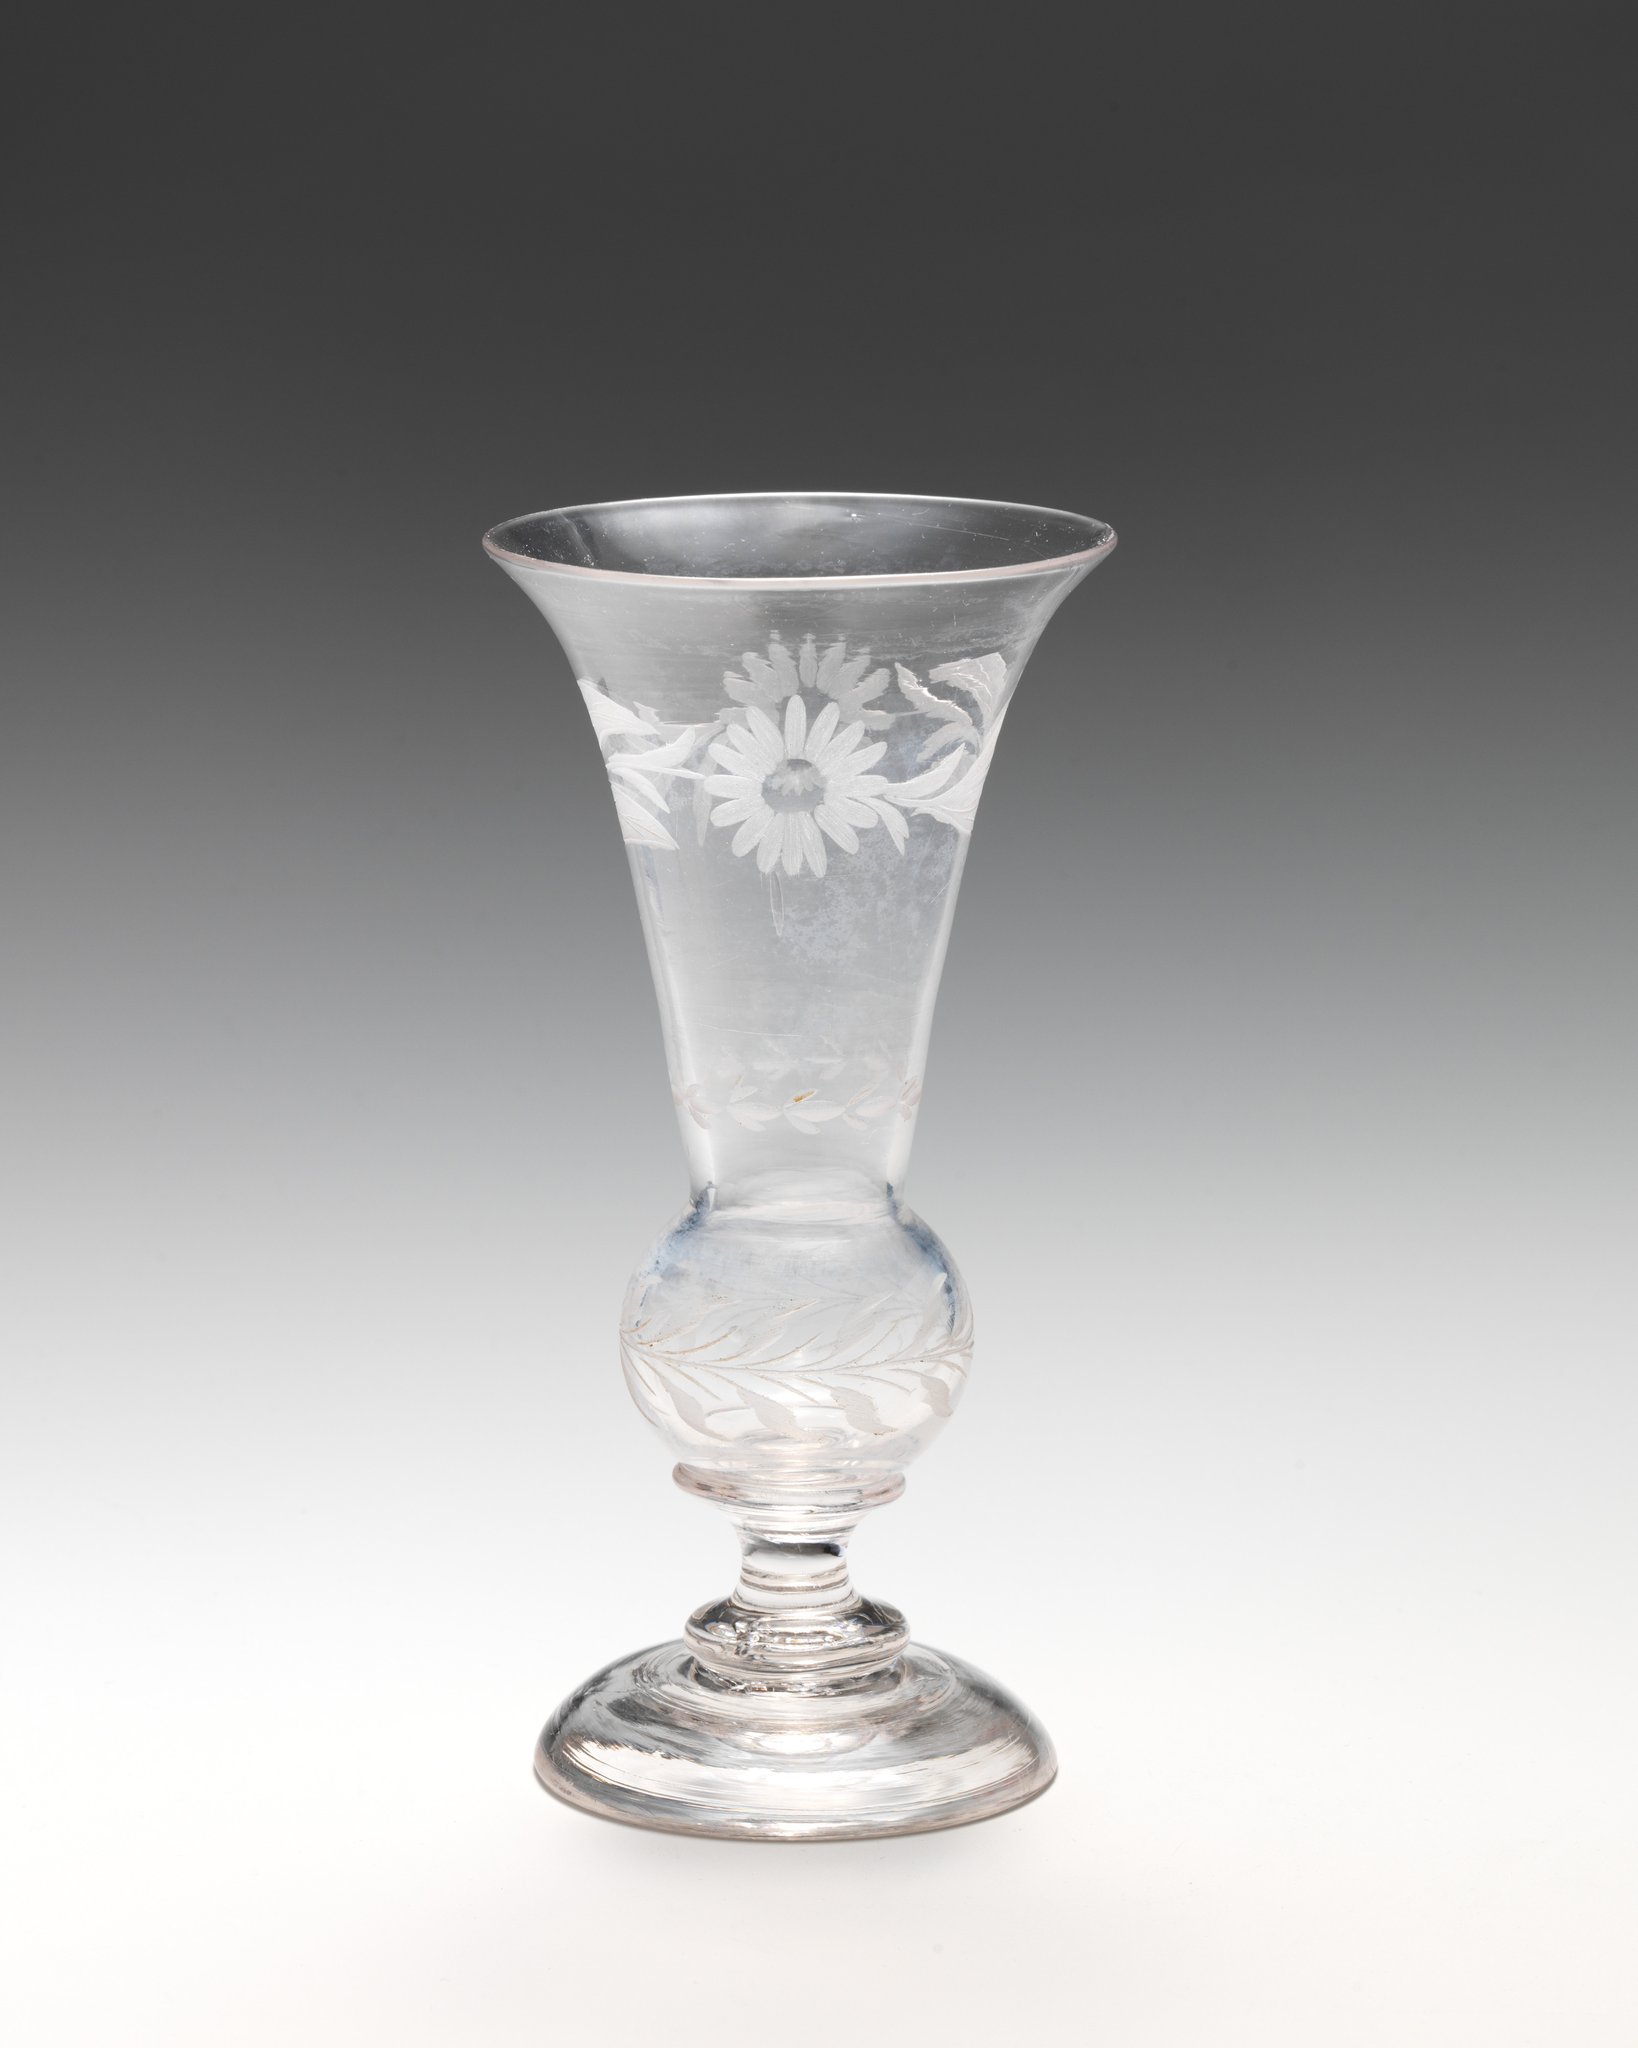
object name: wineglass or vase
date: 1767-1833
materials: glass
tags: flowers